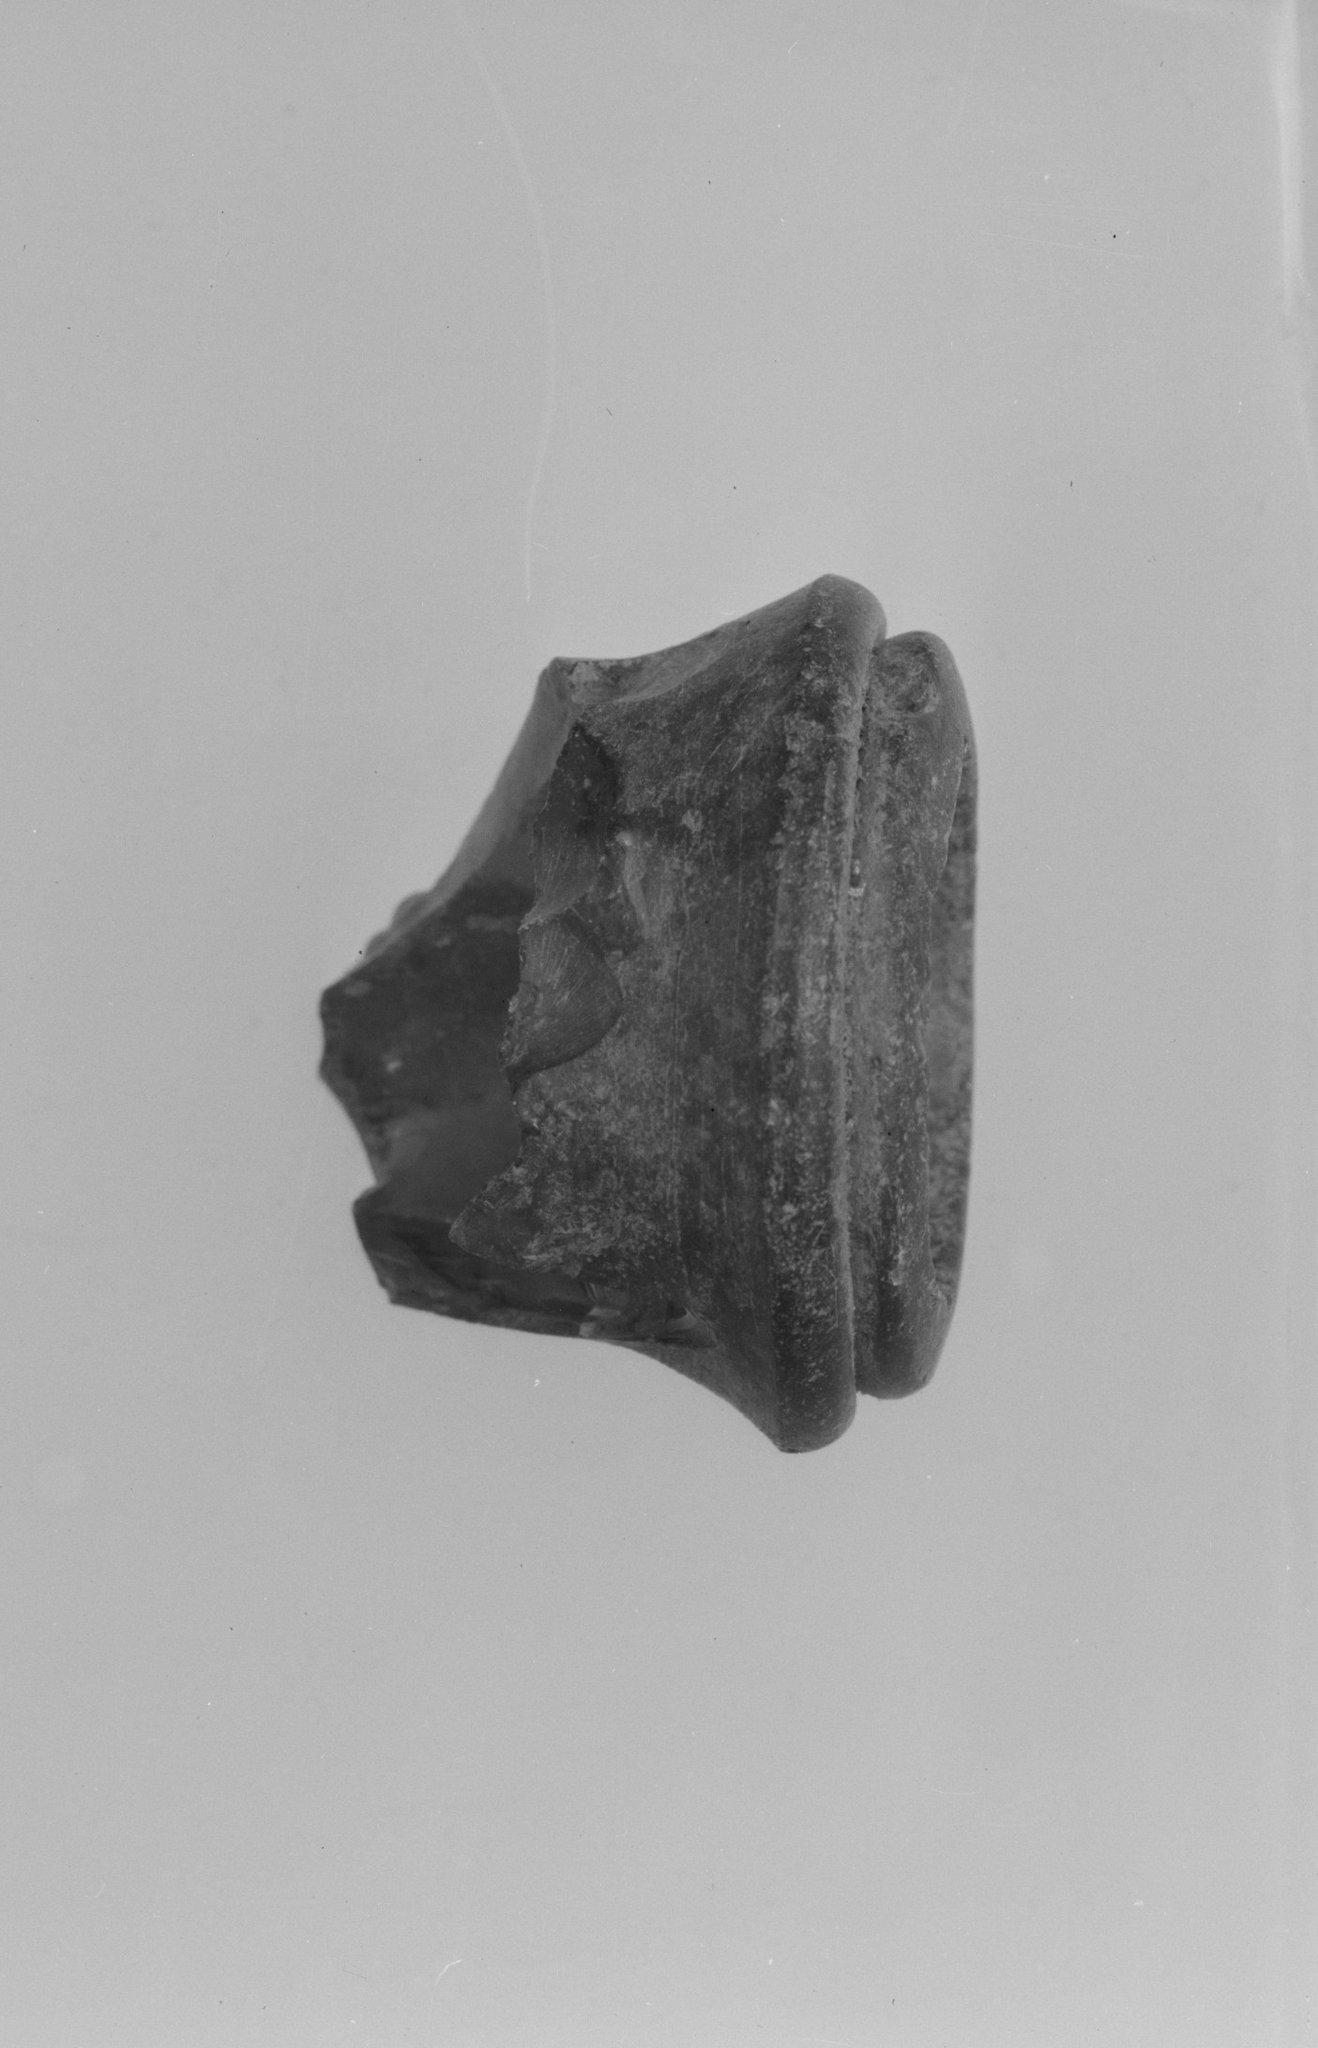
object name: bottle fragment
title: Fragment of a Bottle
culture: american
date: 1701-1800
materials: glass, lead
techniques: glassblowing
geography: united states